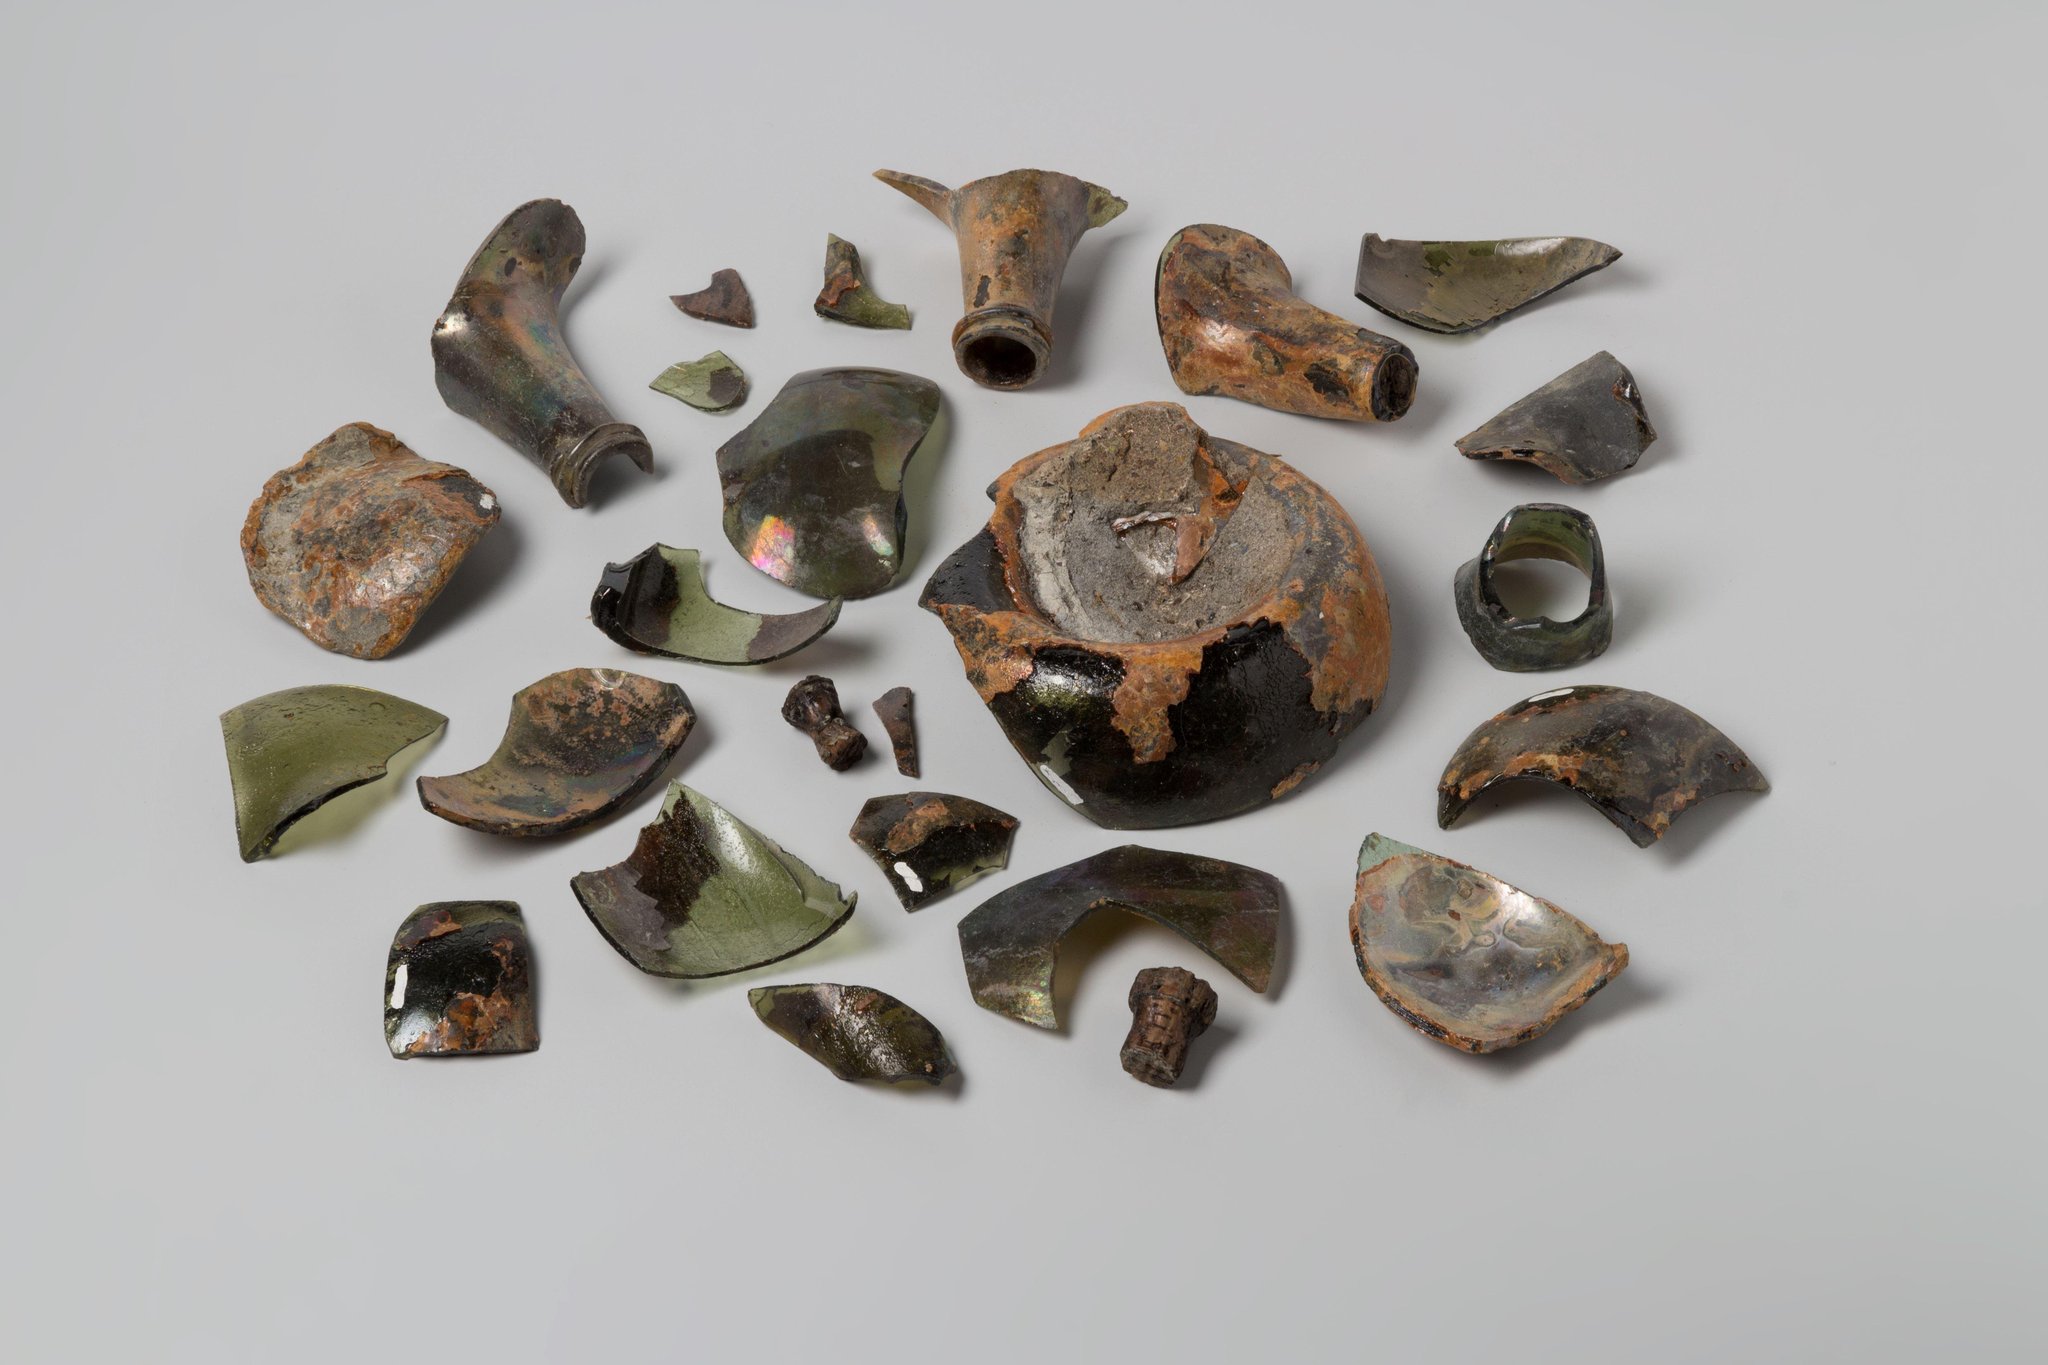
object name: wine bottle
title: Fragmenten van wijnflessen uit het wrak van de Oost-Indiëvaarder 't Vliegend Hart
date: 1700-1735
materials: cork, glass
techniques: manufacturing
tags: 't vliegend hart (schip), verenigde oostindische compagnie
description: Sterk gecorrodeerde glasscherven van wijnflessen. Tussen de scherven bevinden zich twee kurken, vier flessenhalzen en drie bodemfragmenten. Twee kurken zijn geconserveerd (november 1995).